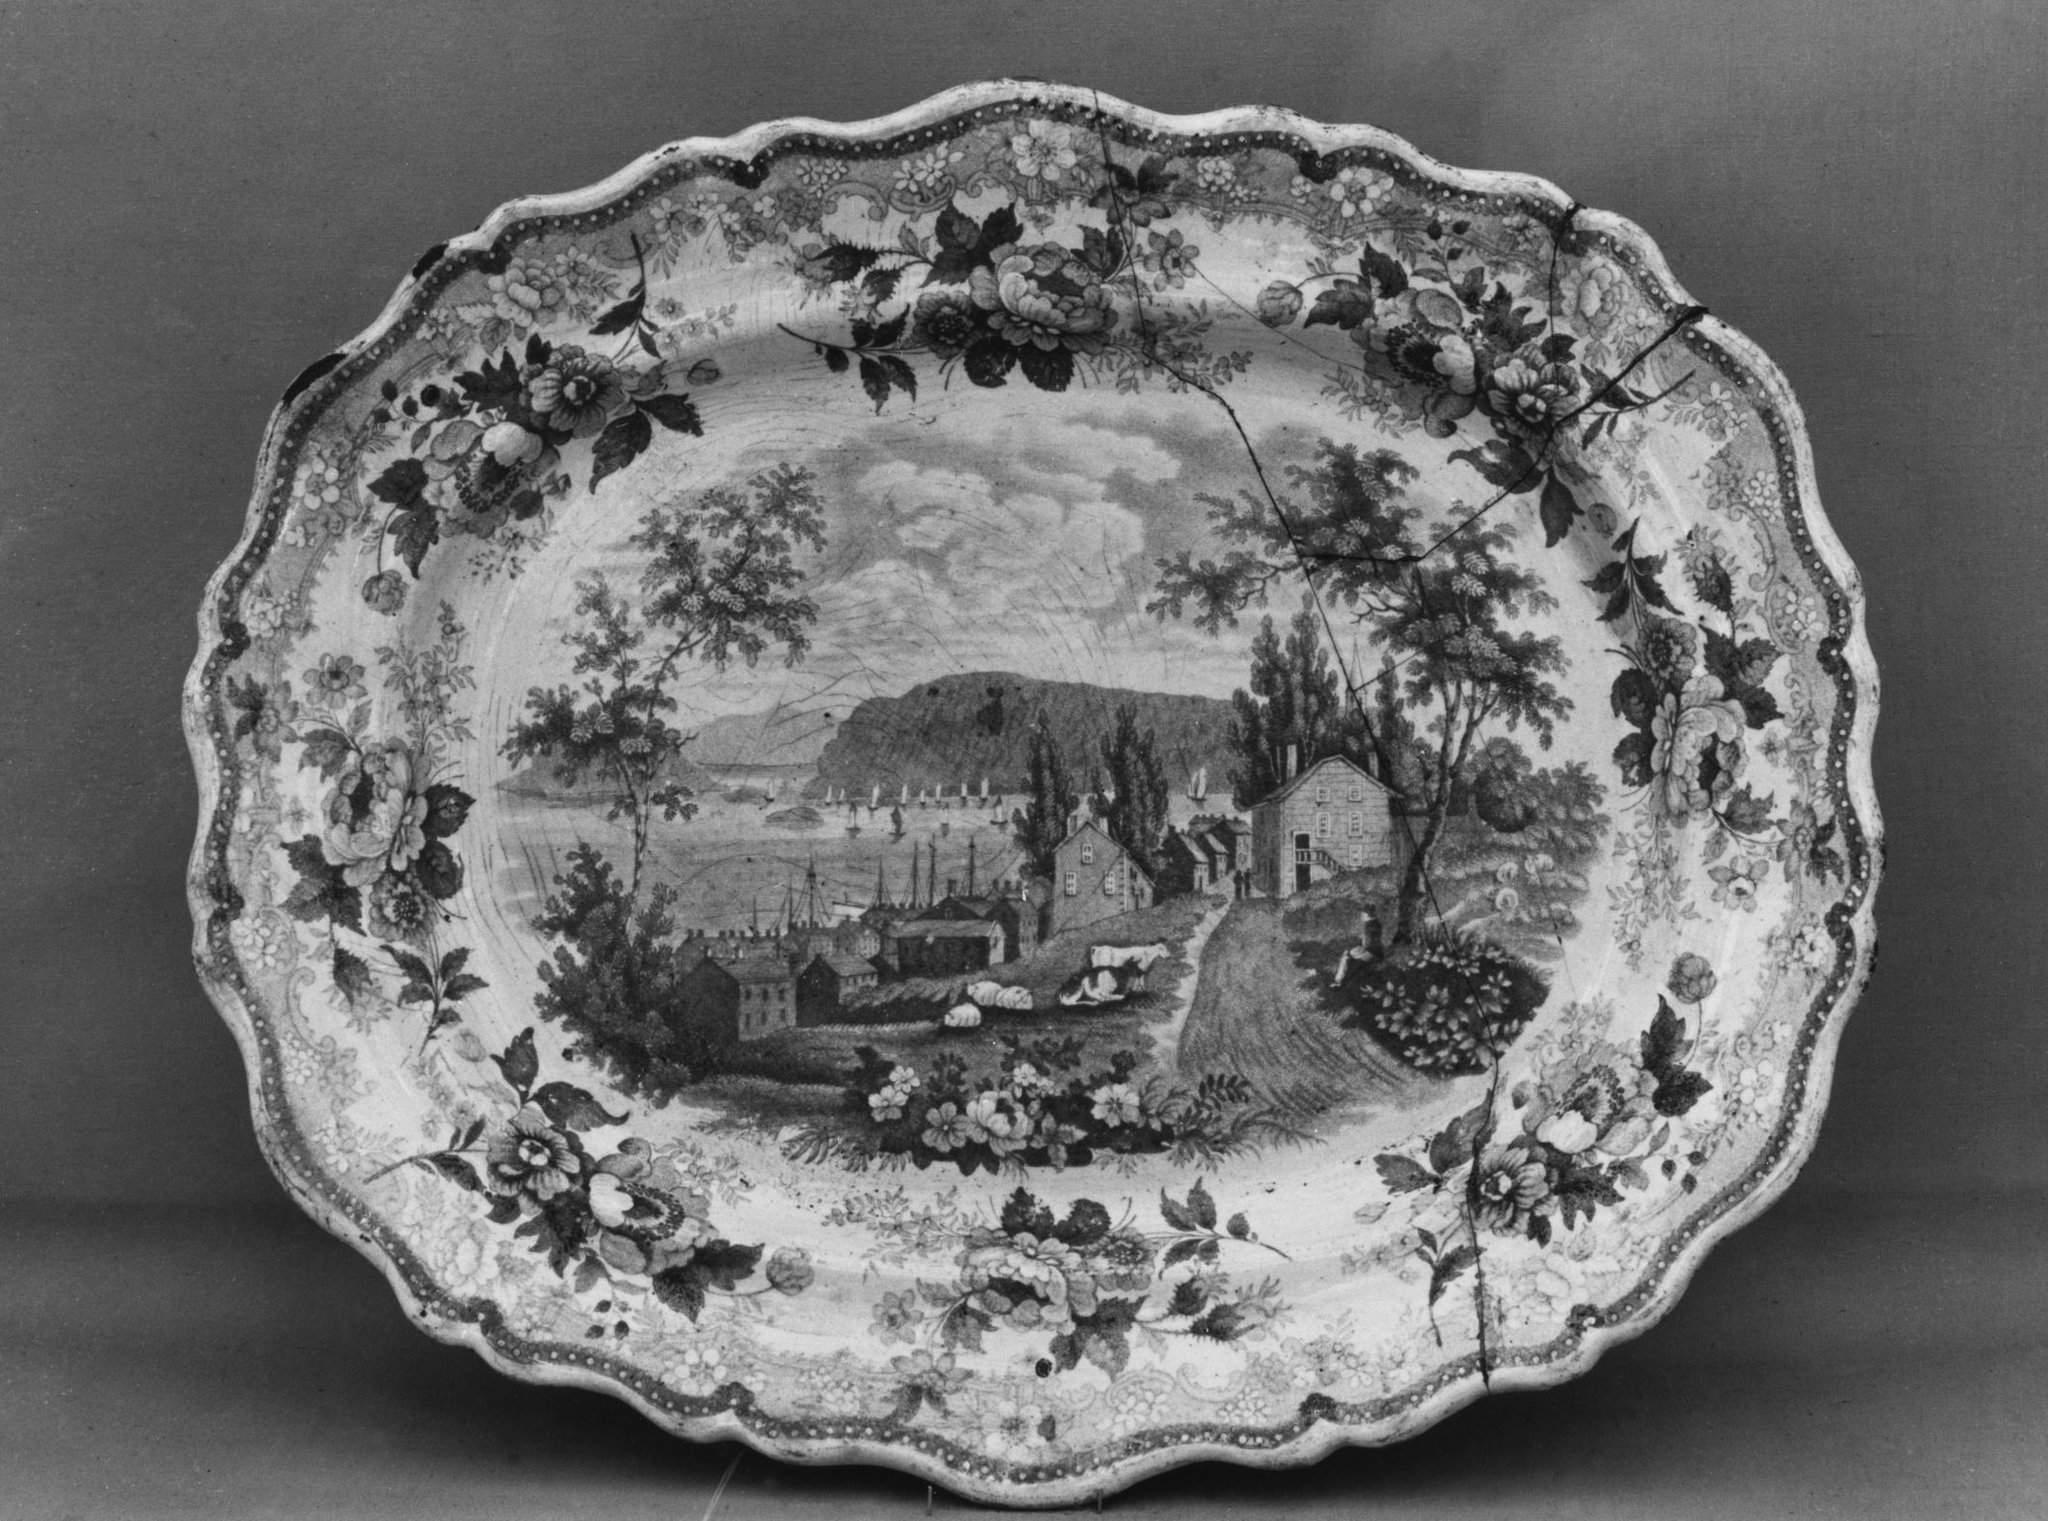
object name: platter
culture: british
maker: job & john jackson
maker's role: maker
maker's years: 1831-1835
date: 1831-1835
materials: earthenware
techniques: transfer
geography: england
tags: flowers,landscapes